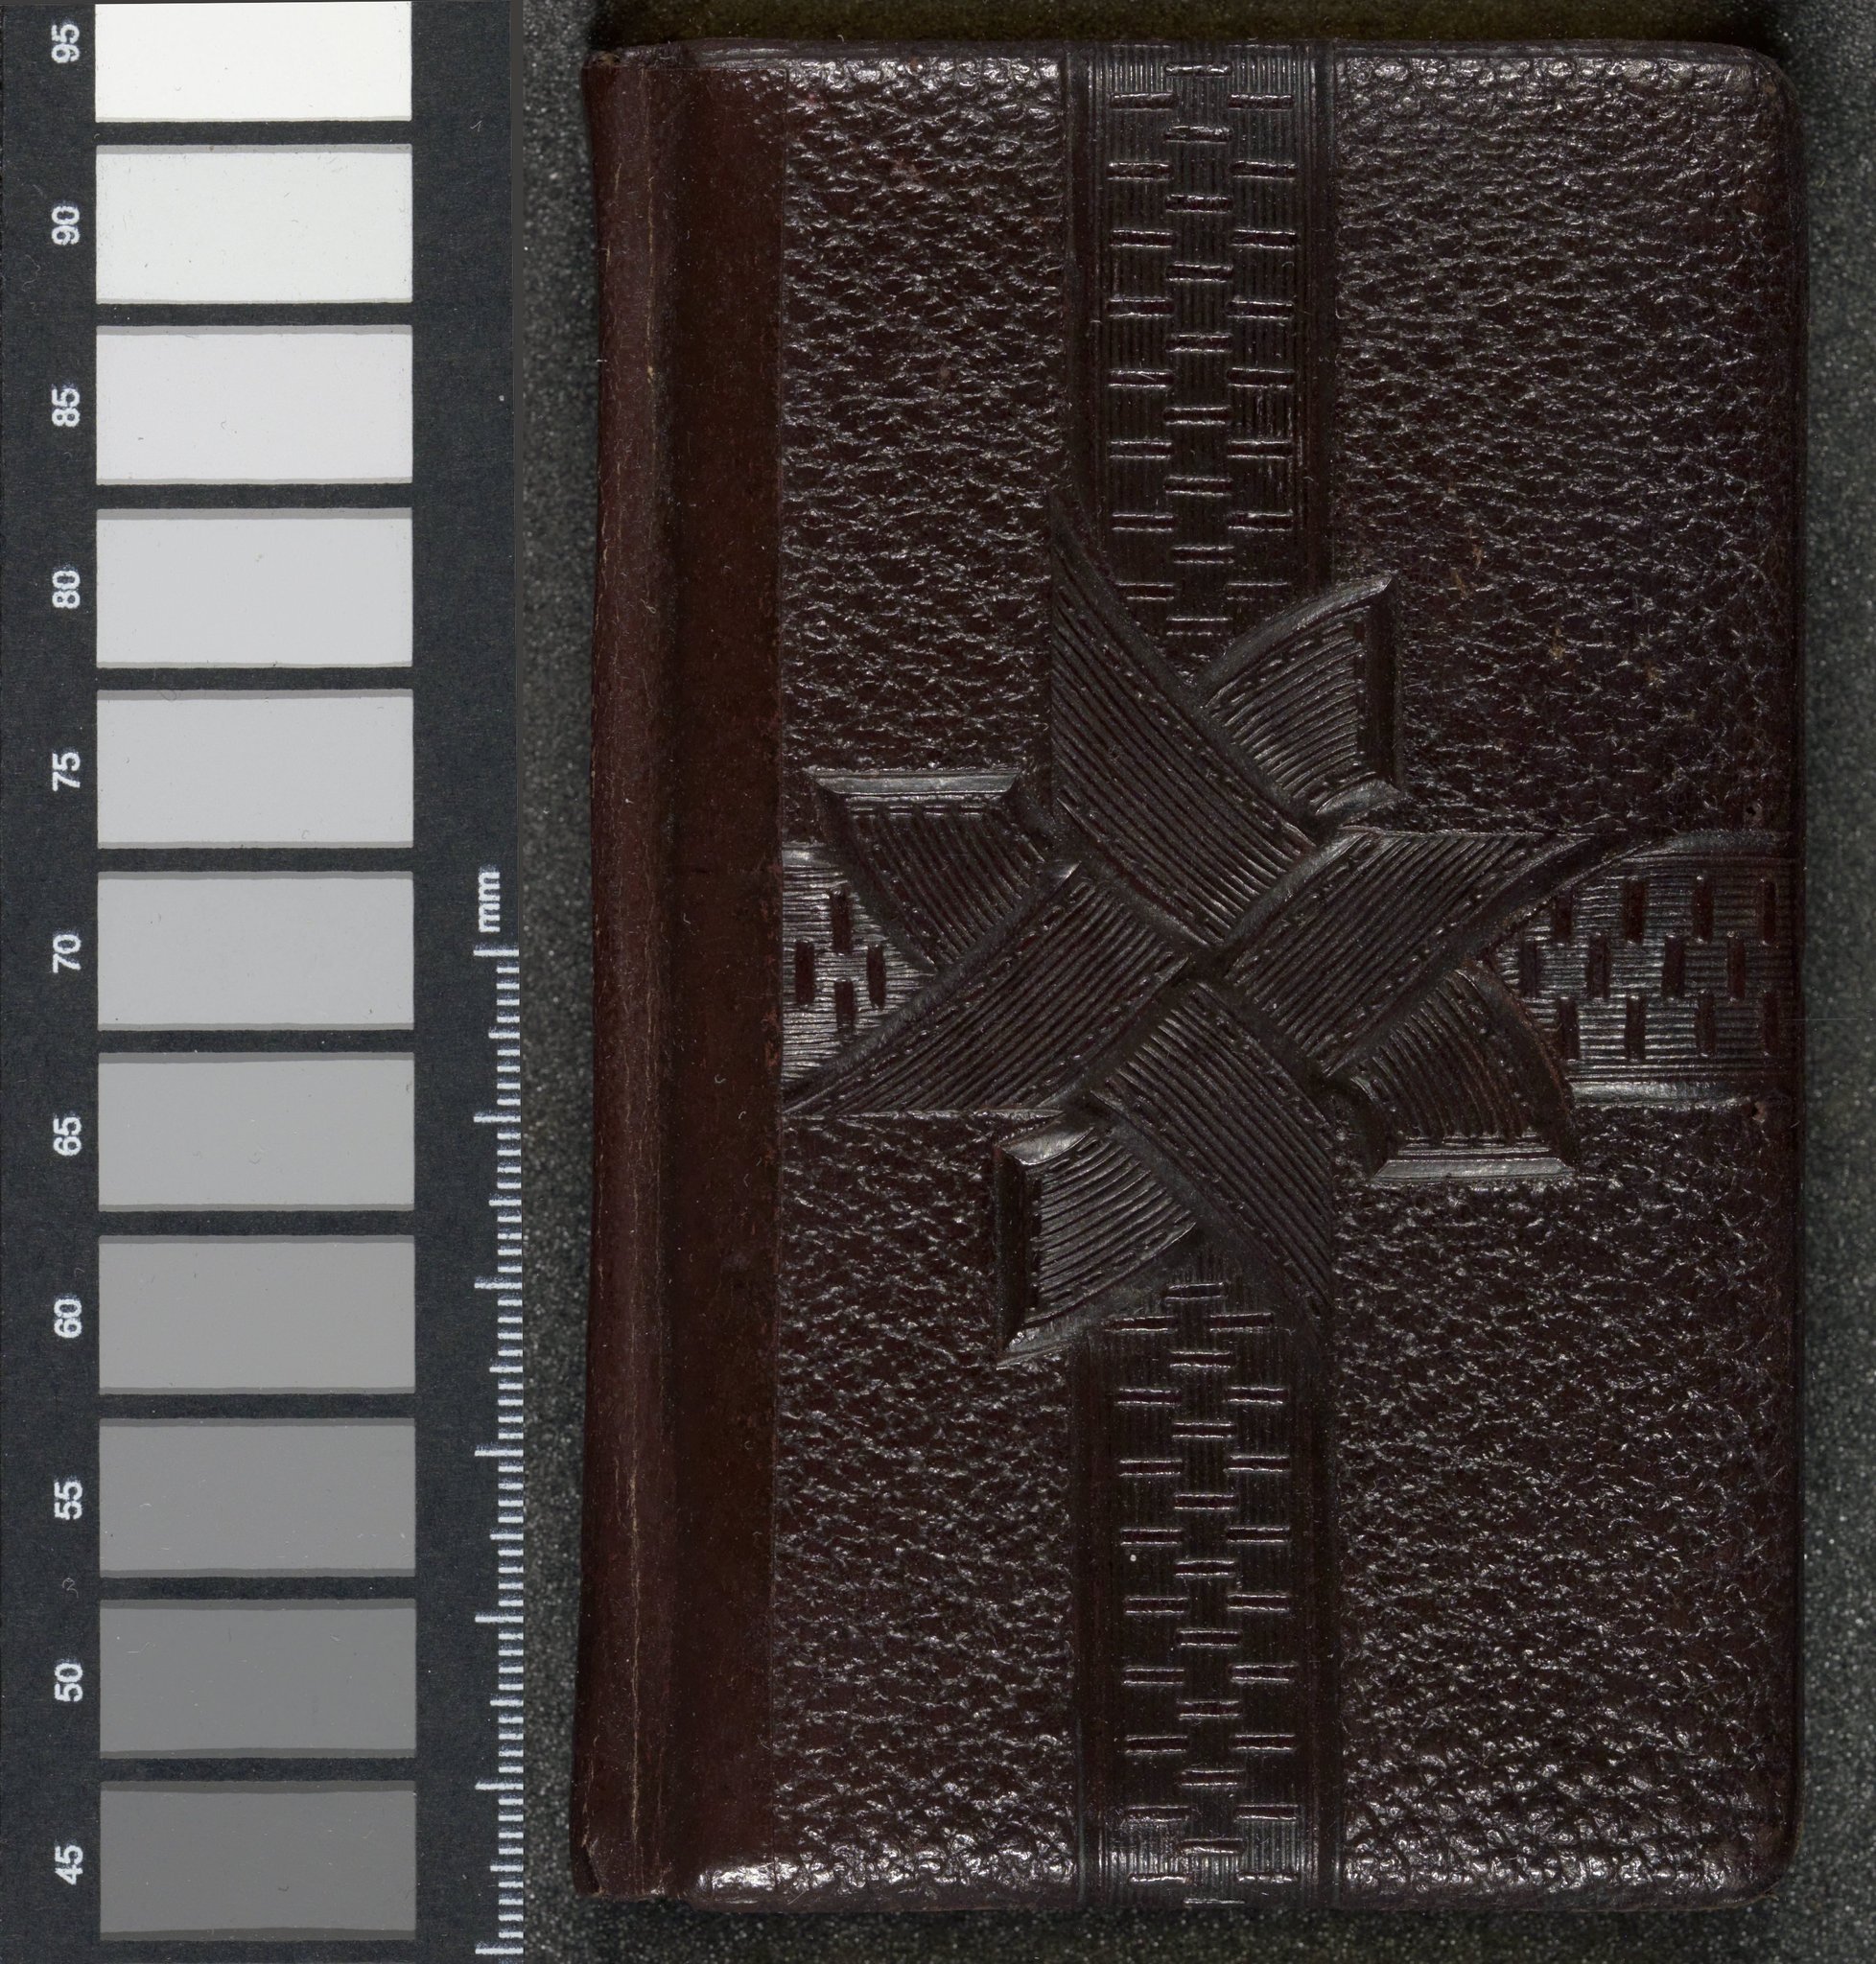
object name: photograph album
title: Album met 12 foto's van een Engelse familie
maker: Anonymous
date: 1890-1910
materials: cardboard, leather, paper, photographic support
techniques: gelatin silver print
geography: england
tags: family, relationship, descent, family life, england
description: Fotoalbum in een bruine leren band. De voorzijde is versierd met een lint met een knoop in reliëf. Het album heeft twaalf bladen met goud op snee, op elk blad een omkaderde passe-partout. Het album bevat twaalf opnames van leden van (vermoedelijk) een Engelse familie.